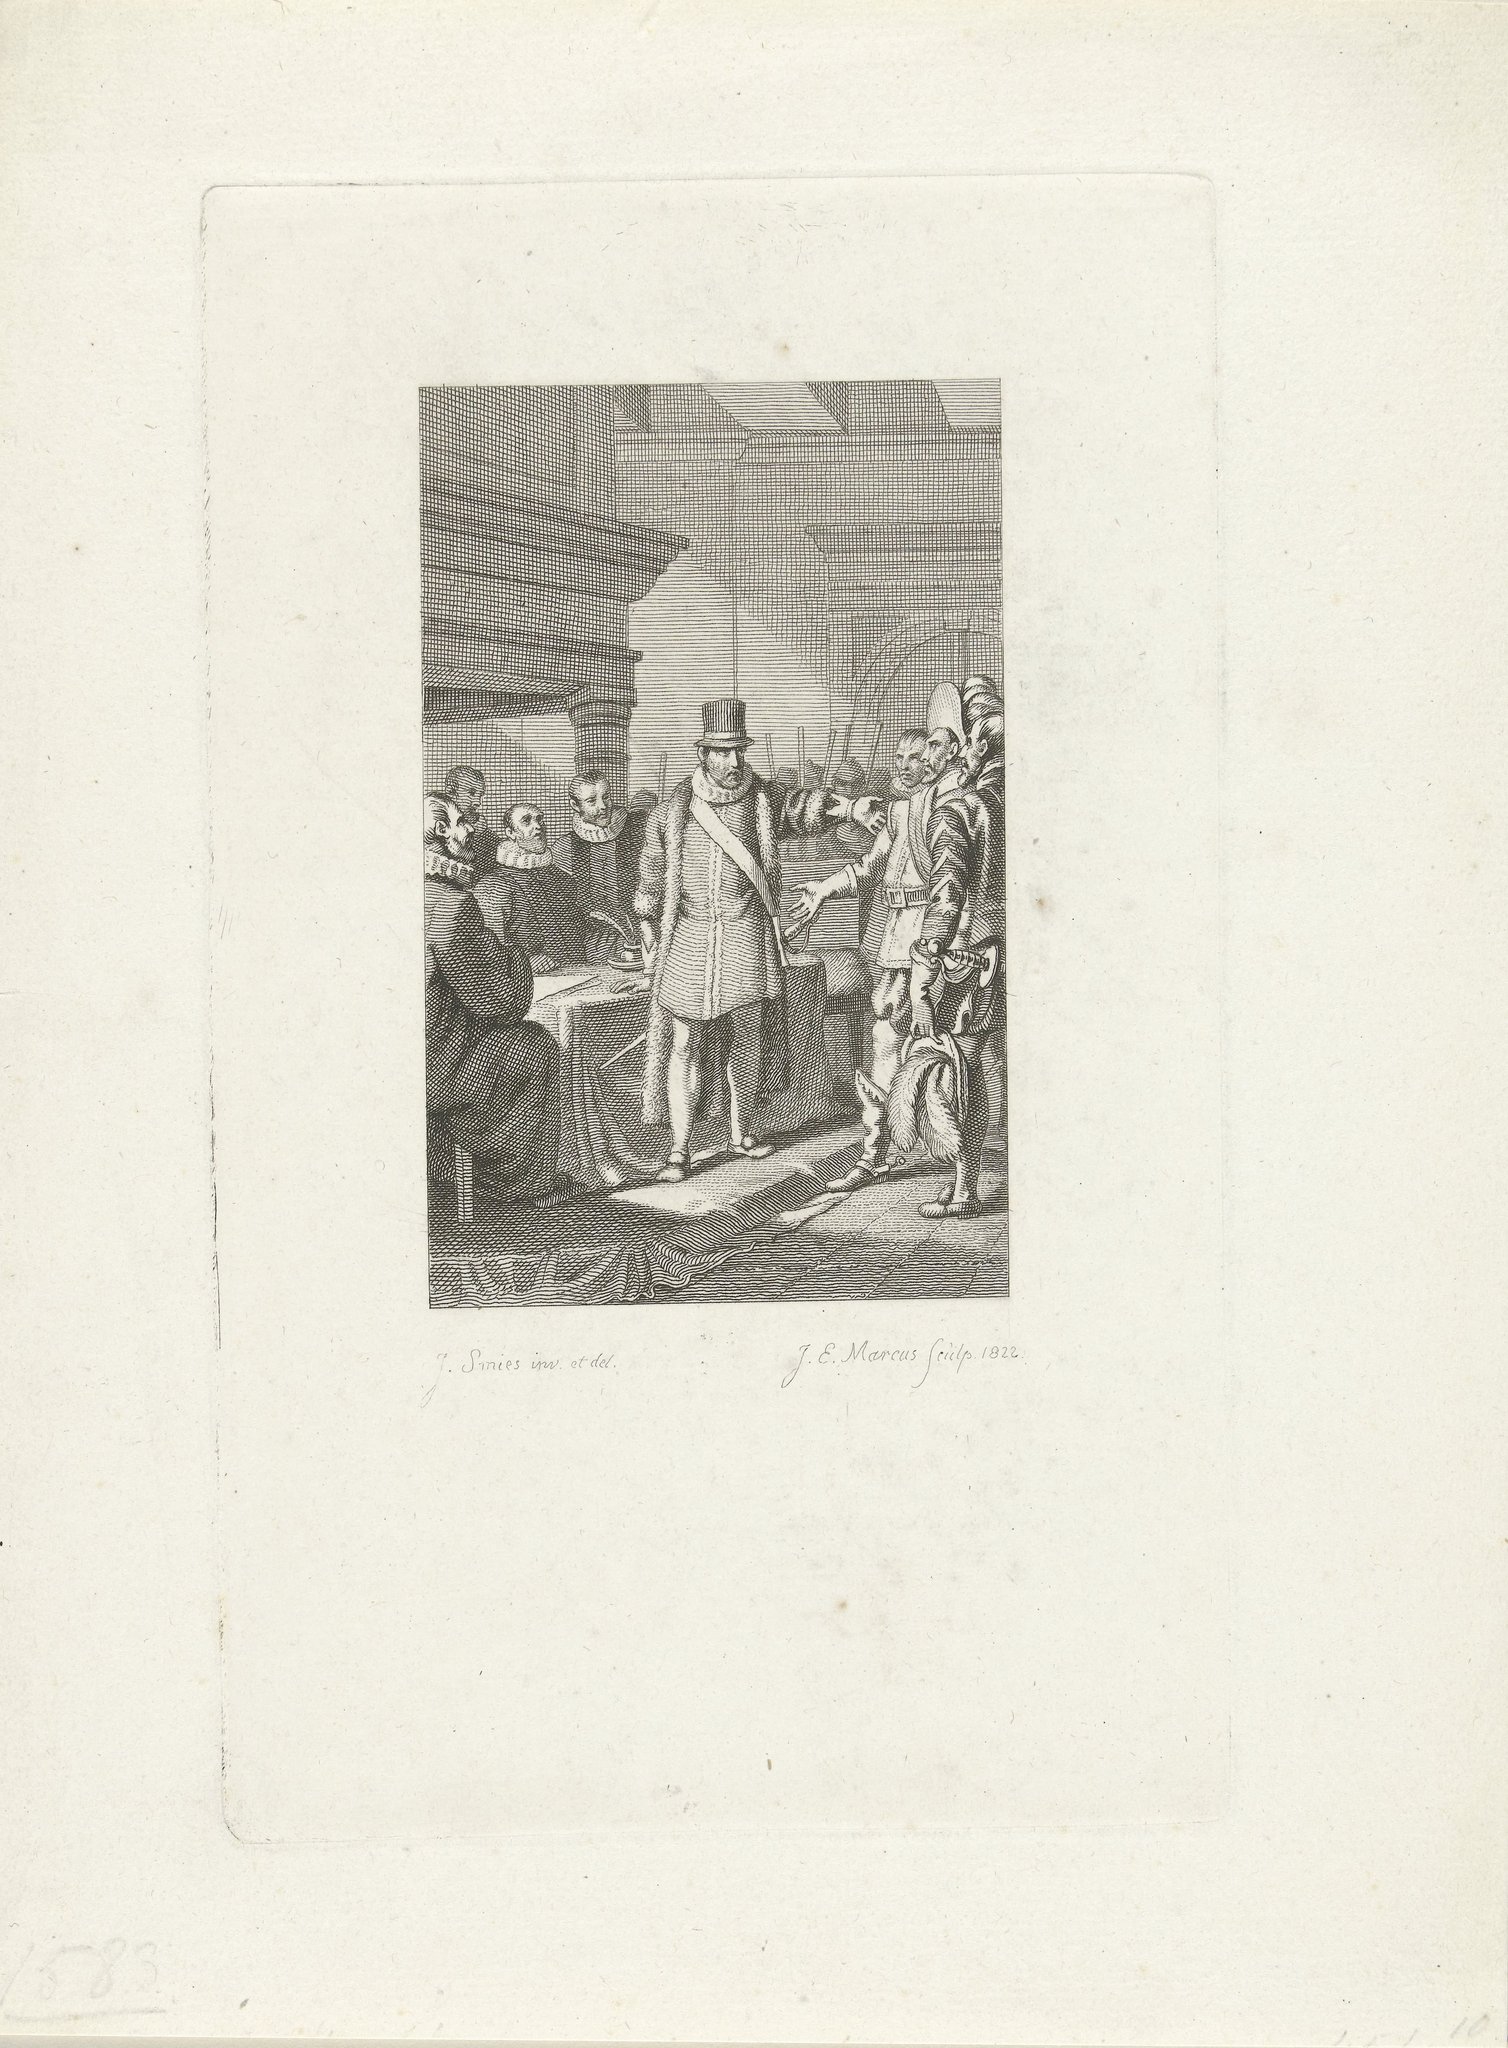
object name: history print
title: Moedige taal van De Gryze te Brussel, 1583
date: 1822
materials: paper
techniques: etching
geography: netherlands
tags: brussels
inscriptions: date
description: Illustratie voor: P.C. Hoofts Nederlandsche historien / met aanteekn. en ophelderingen van M. Siegenbeek, A. Simons en J.P. van Cappelle. J. van der Hey, Amsterdam 1820-1824.